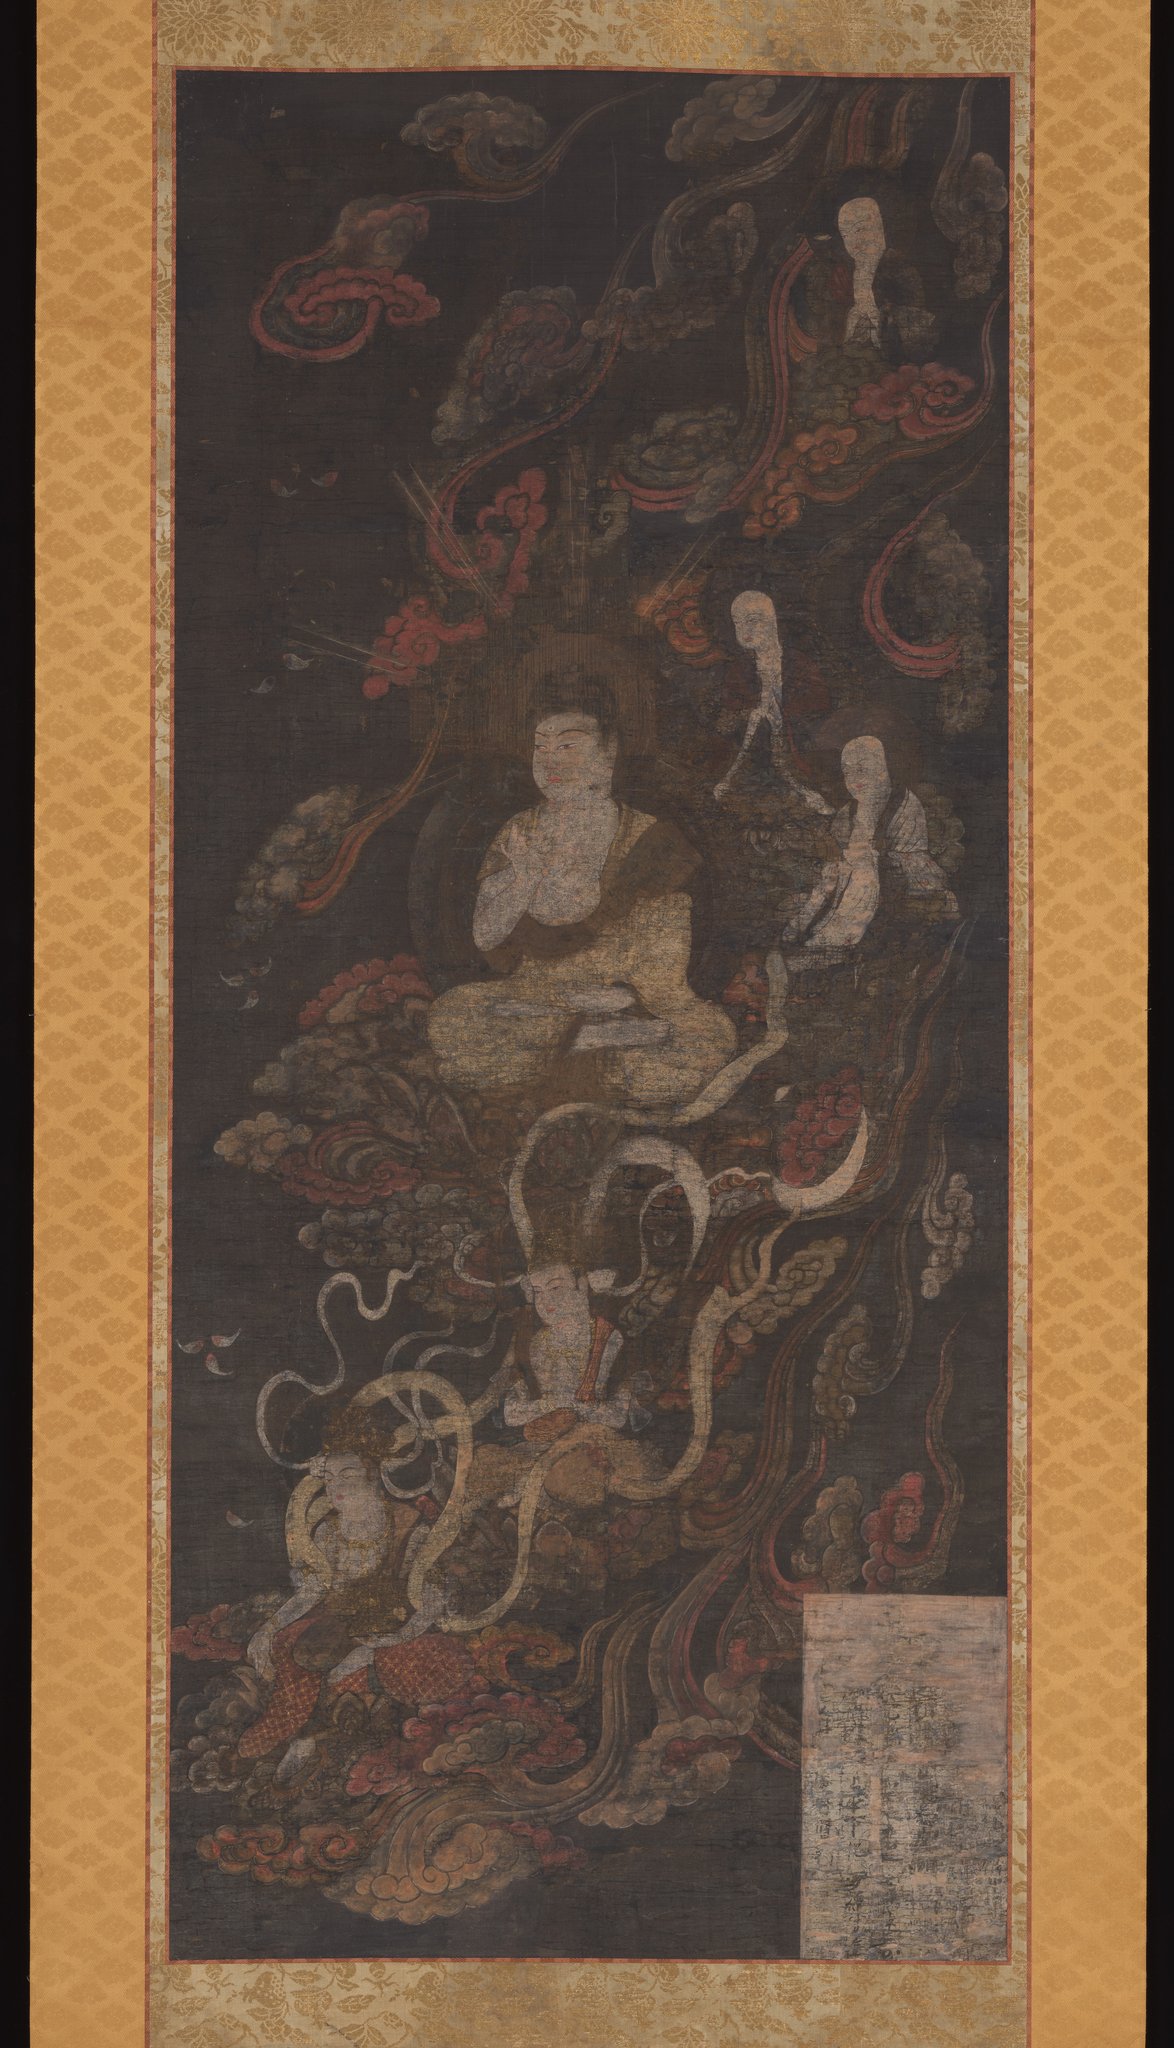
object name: hanging scroll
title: Welcoming Descent of Amida, the Buddha of Infinite Light, and His Holy Retinue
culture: japanese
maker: unidentified artist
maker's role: artist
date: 1301-1400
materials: gold, gold leaf, ink, silk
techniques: cutting, kirikane